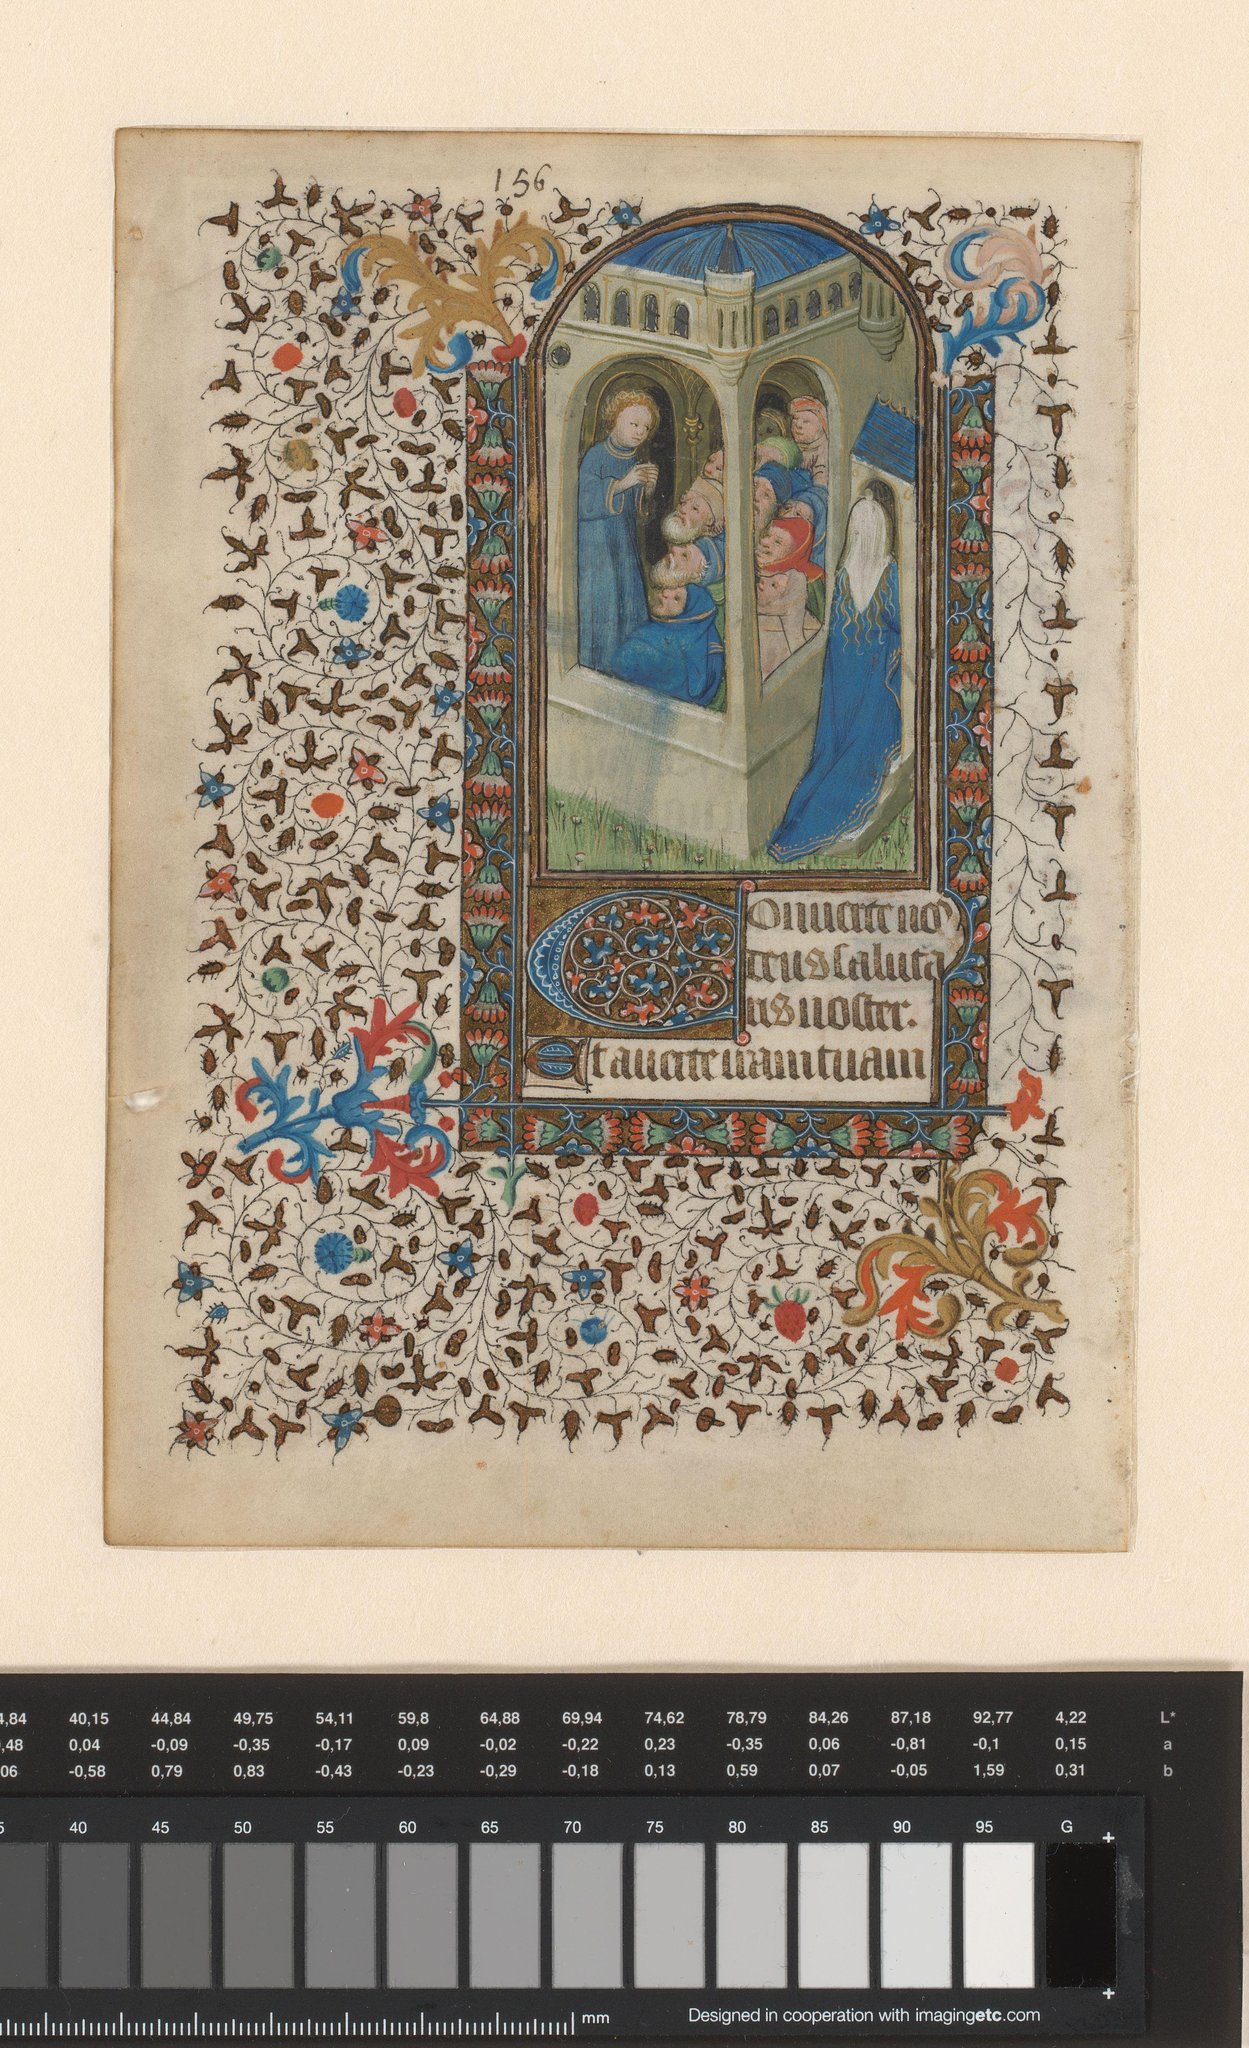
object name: miniature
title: Blad uit een getijdenboek met Christus voor de schriftgeleerden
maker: Anonymous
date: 1400-1449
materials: paint, gold leaf, ink, parchment, watercolor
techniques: brush, pen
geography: northern france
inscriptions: number: ‘156’